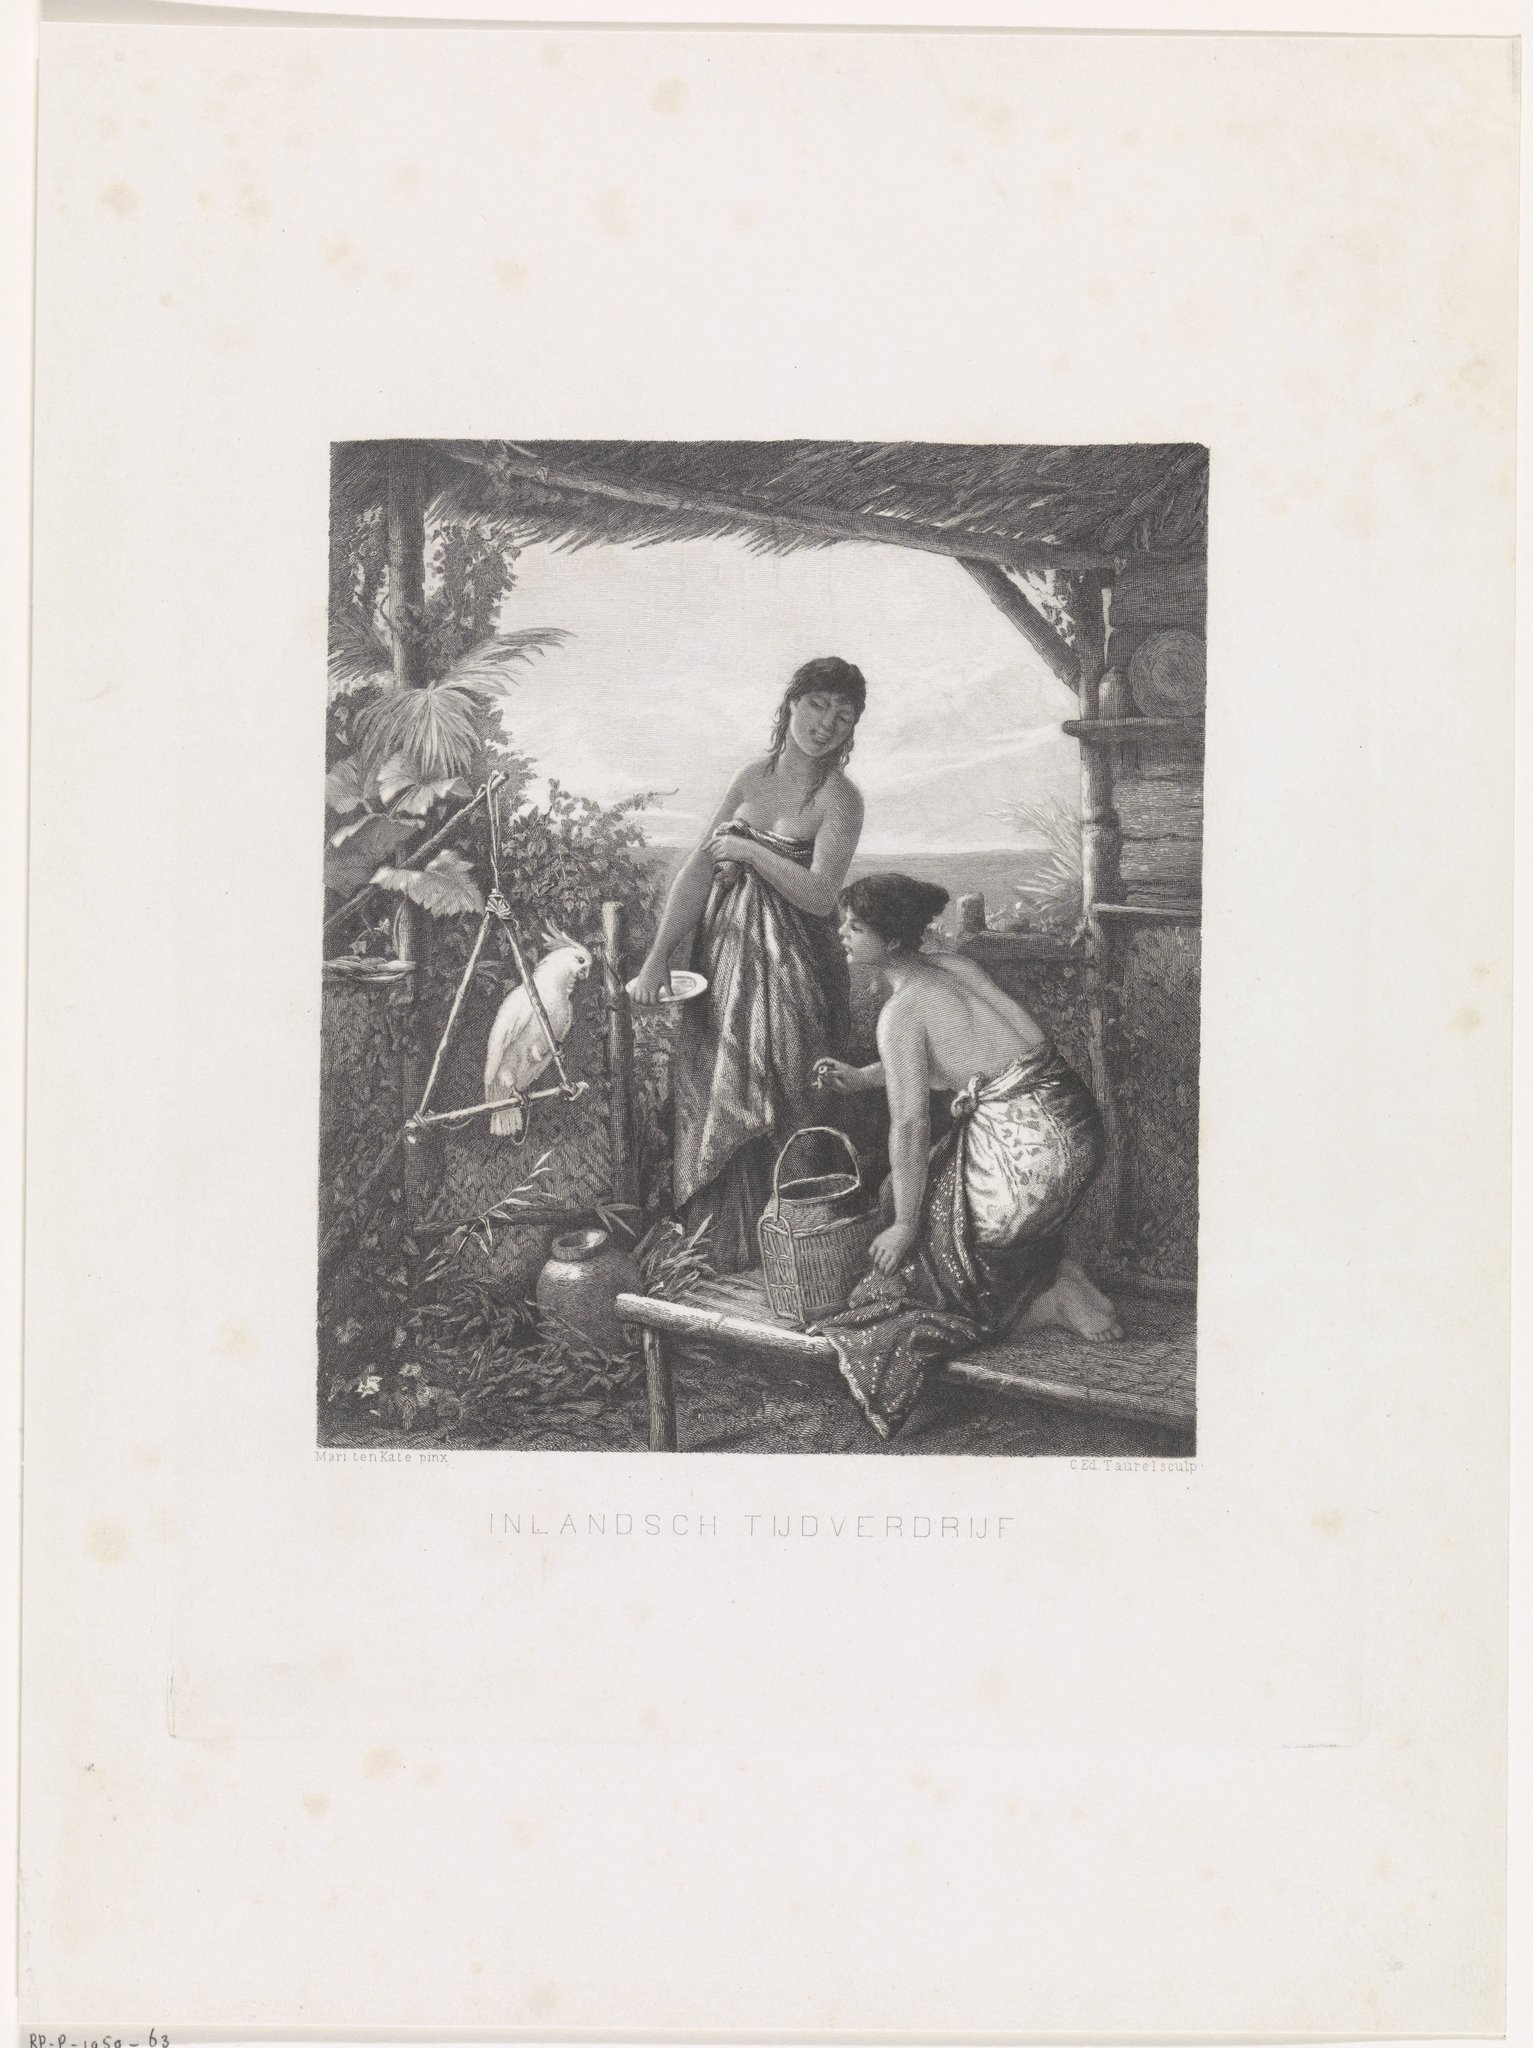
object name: print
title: Inlandsch tijdverdrijf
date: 1841-1892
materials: paper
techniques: engraving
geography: amsterdam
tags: asiatic races and peoples, adolescent, young woman, maiden, ornamental birds: parrot, indonesia